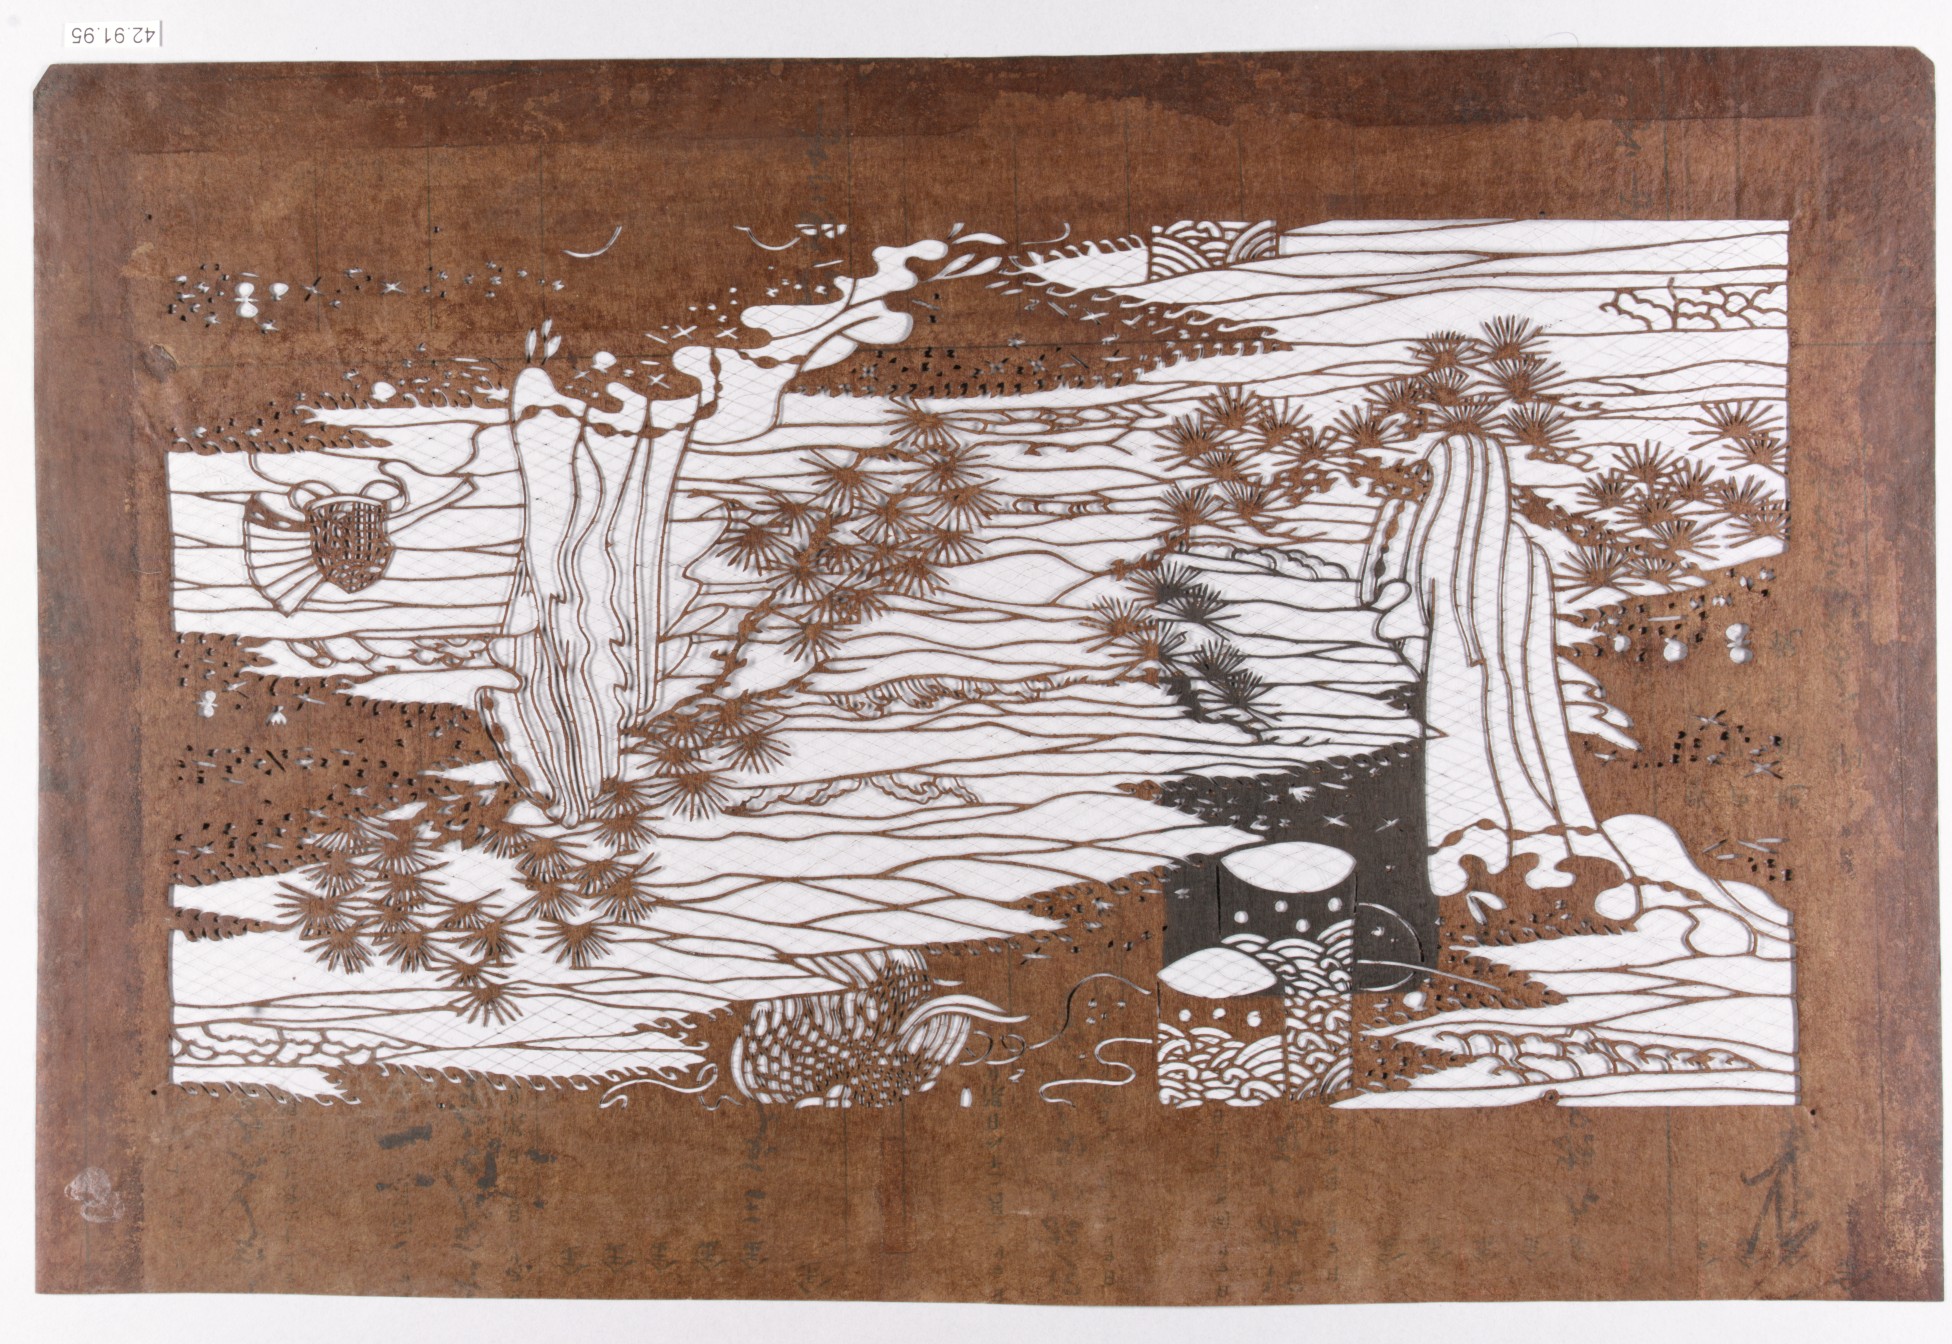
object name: stencil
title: Stencil with Theme from Matsukaze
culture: japanese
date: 1801-1900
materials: paper, silk